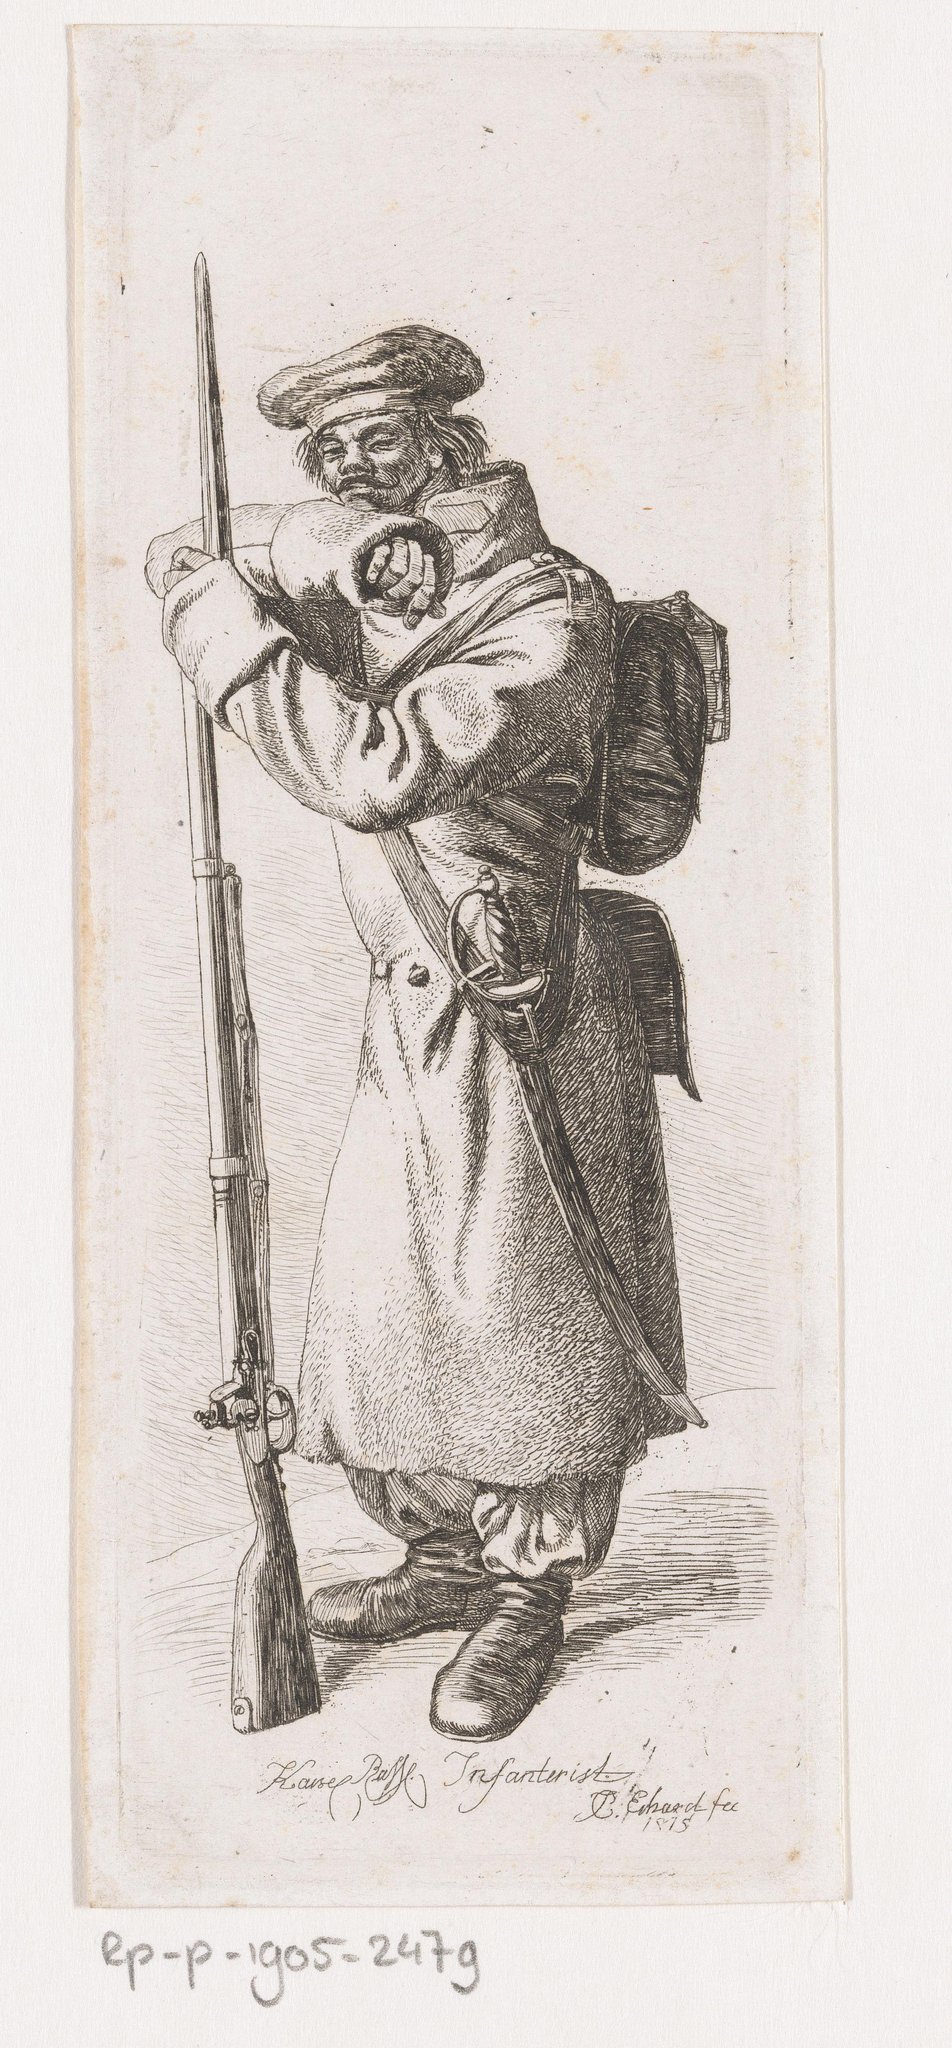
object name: print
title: Russische soldaat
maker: johann christoph erhard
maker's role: print maker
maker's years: 1795-1882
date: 1815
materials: paper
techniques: etching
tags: helved weapons, polearms (for striking, hacking, thrusting) (with name), private soldier (+ infantry), hacking and thrusting weapons: sword, firearms: rifle, europeans (with name)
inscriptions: collector's mark: Lugt 2228